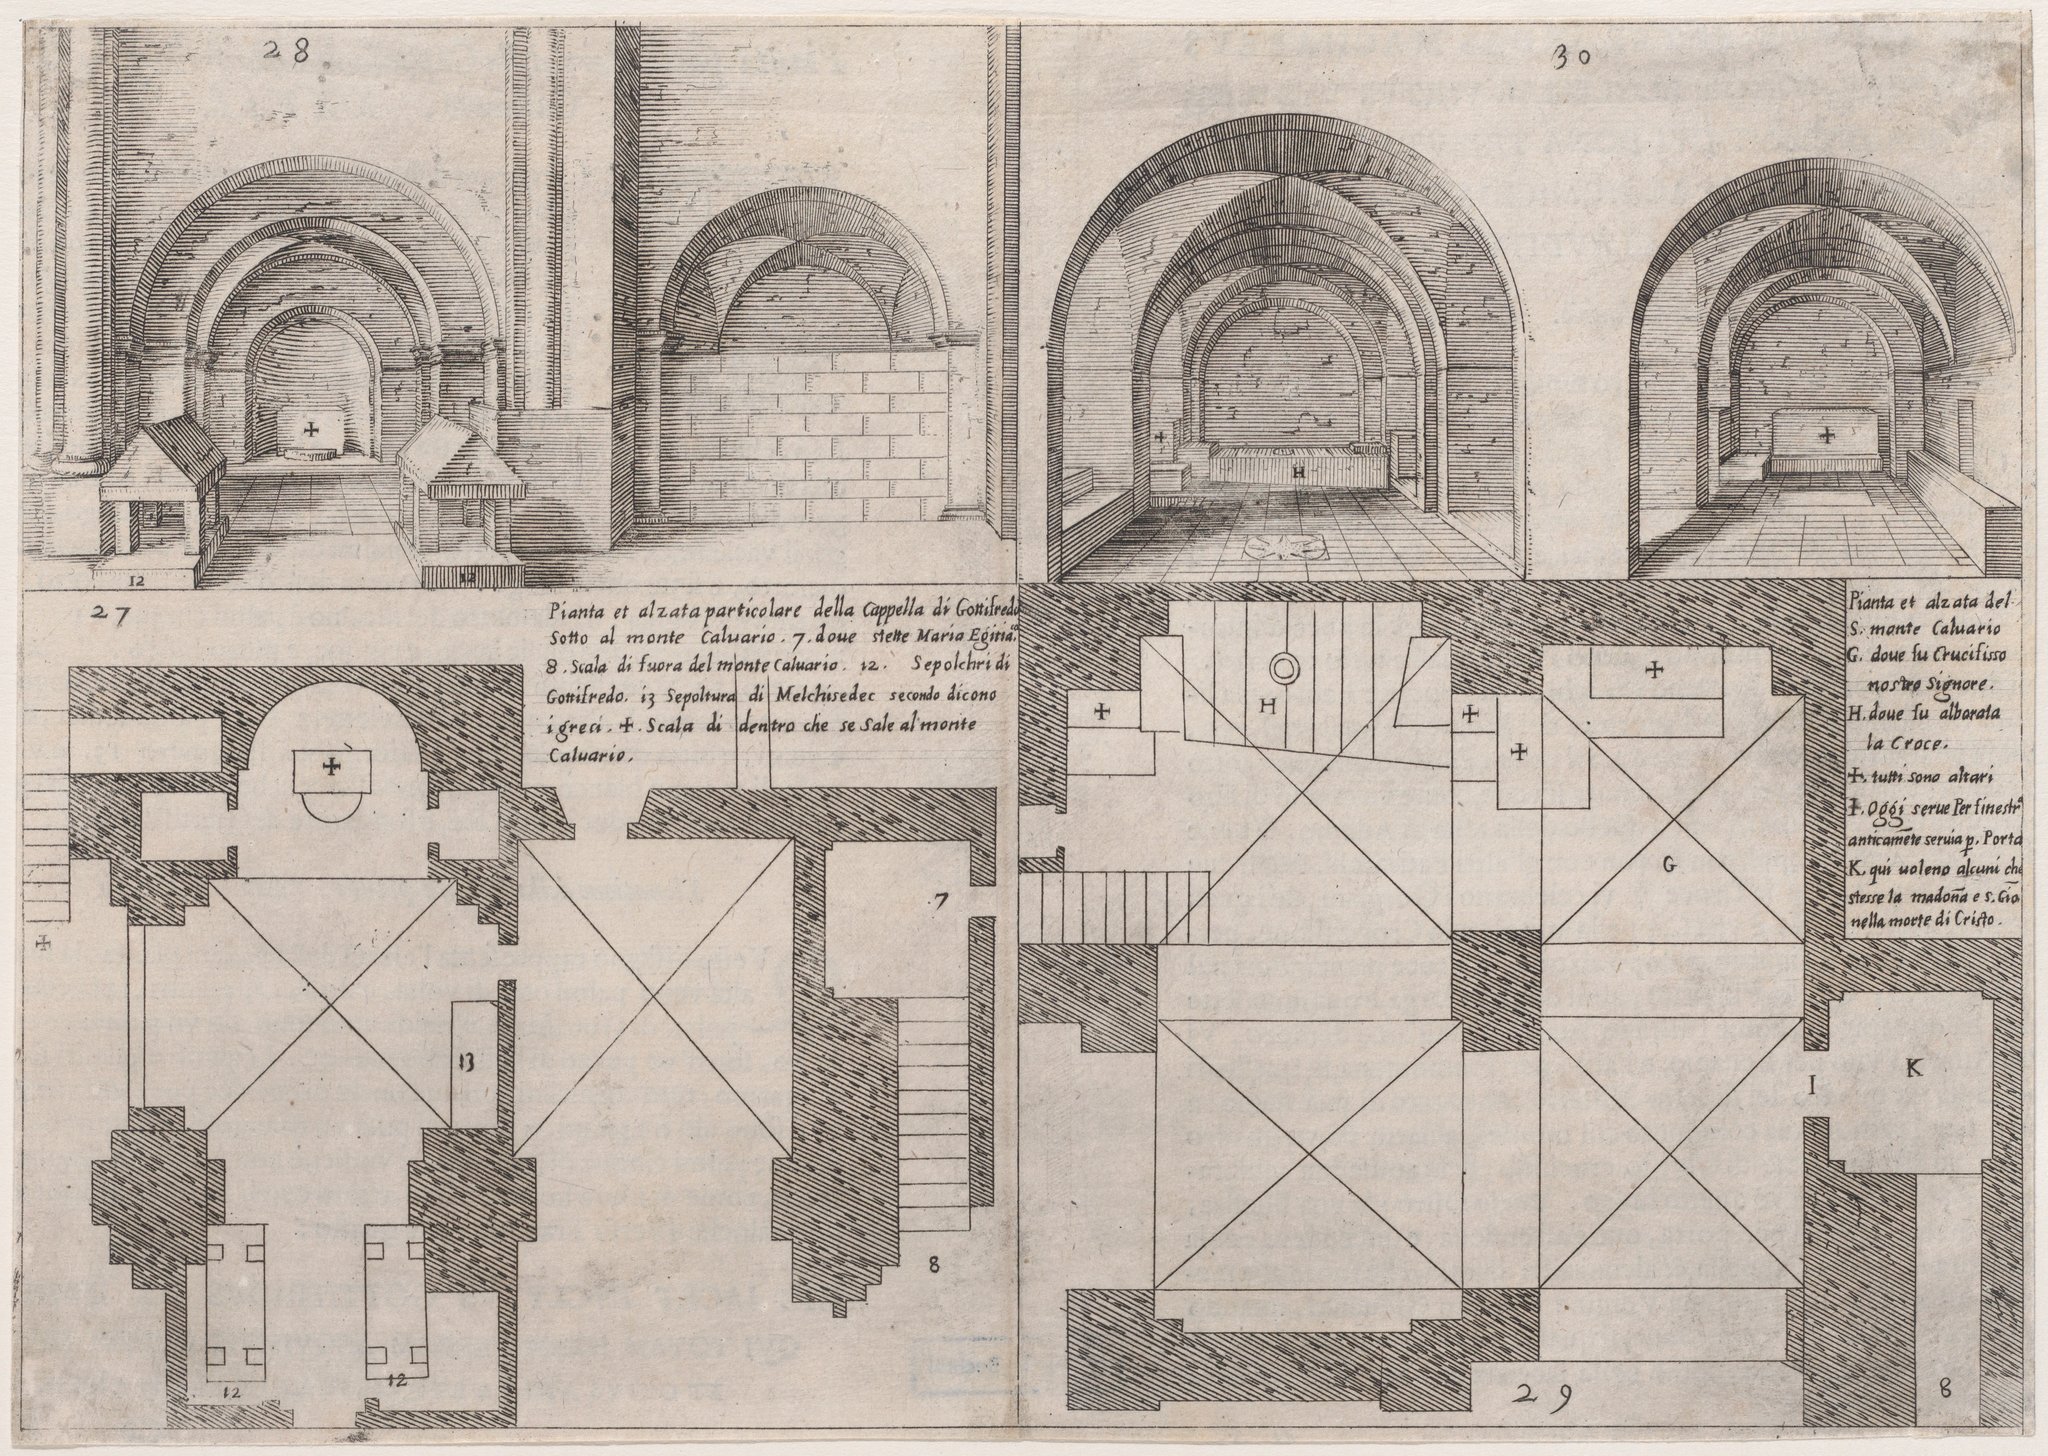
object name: print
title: Plate 23, from "Trattato delle Piante & Immagini de Sacri Edifizi di Terra Santa" (Treatise of the Plans & Images of the Sacred Buildings of the Holy Land)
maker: jacques callot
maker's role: artist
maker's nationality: french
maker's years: 1592-1635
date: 1620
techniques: engraving, etching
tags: architecture,buildings